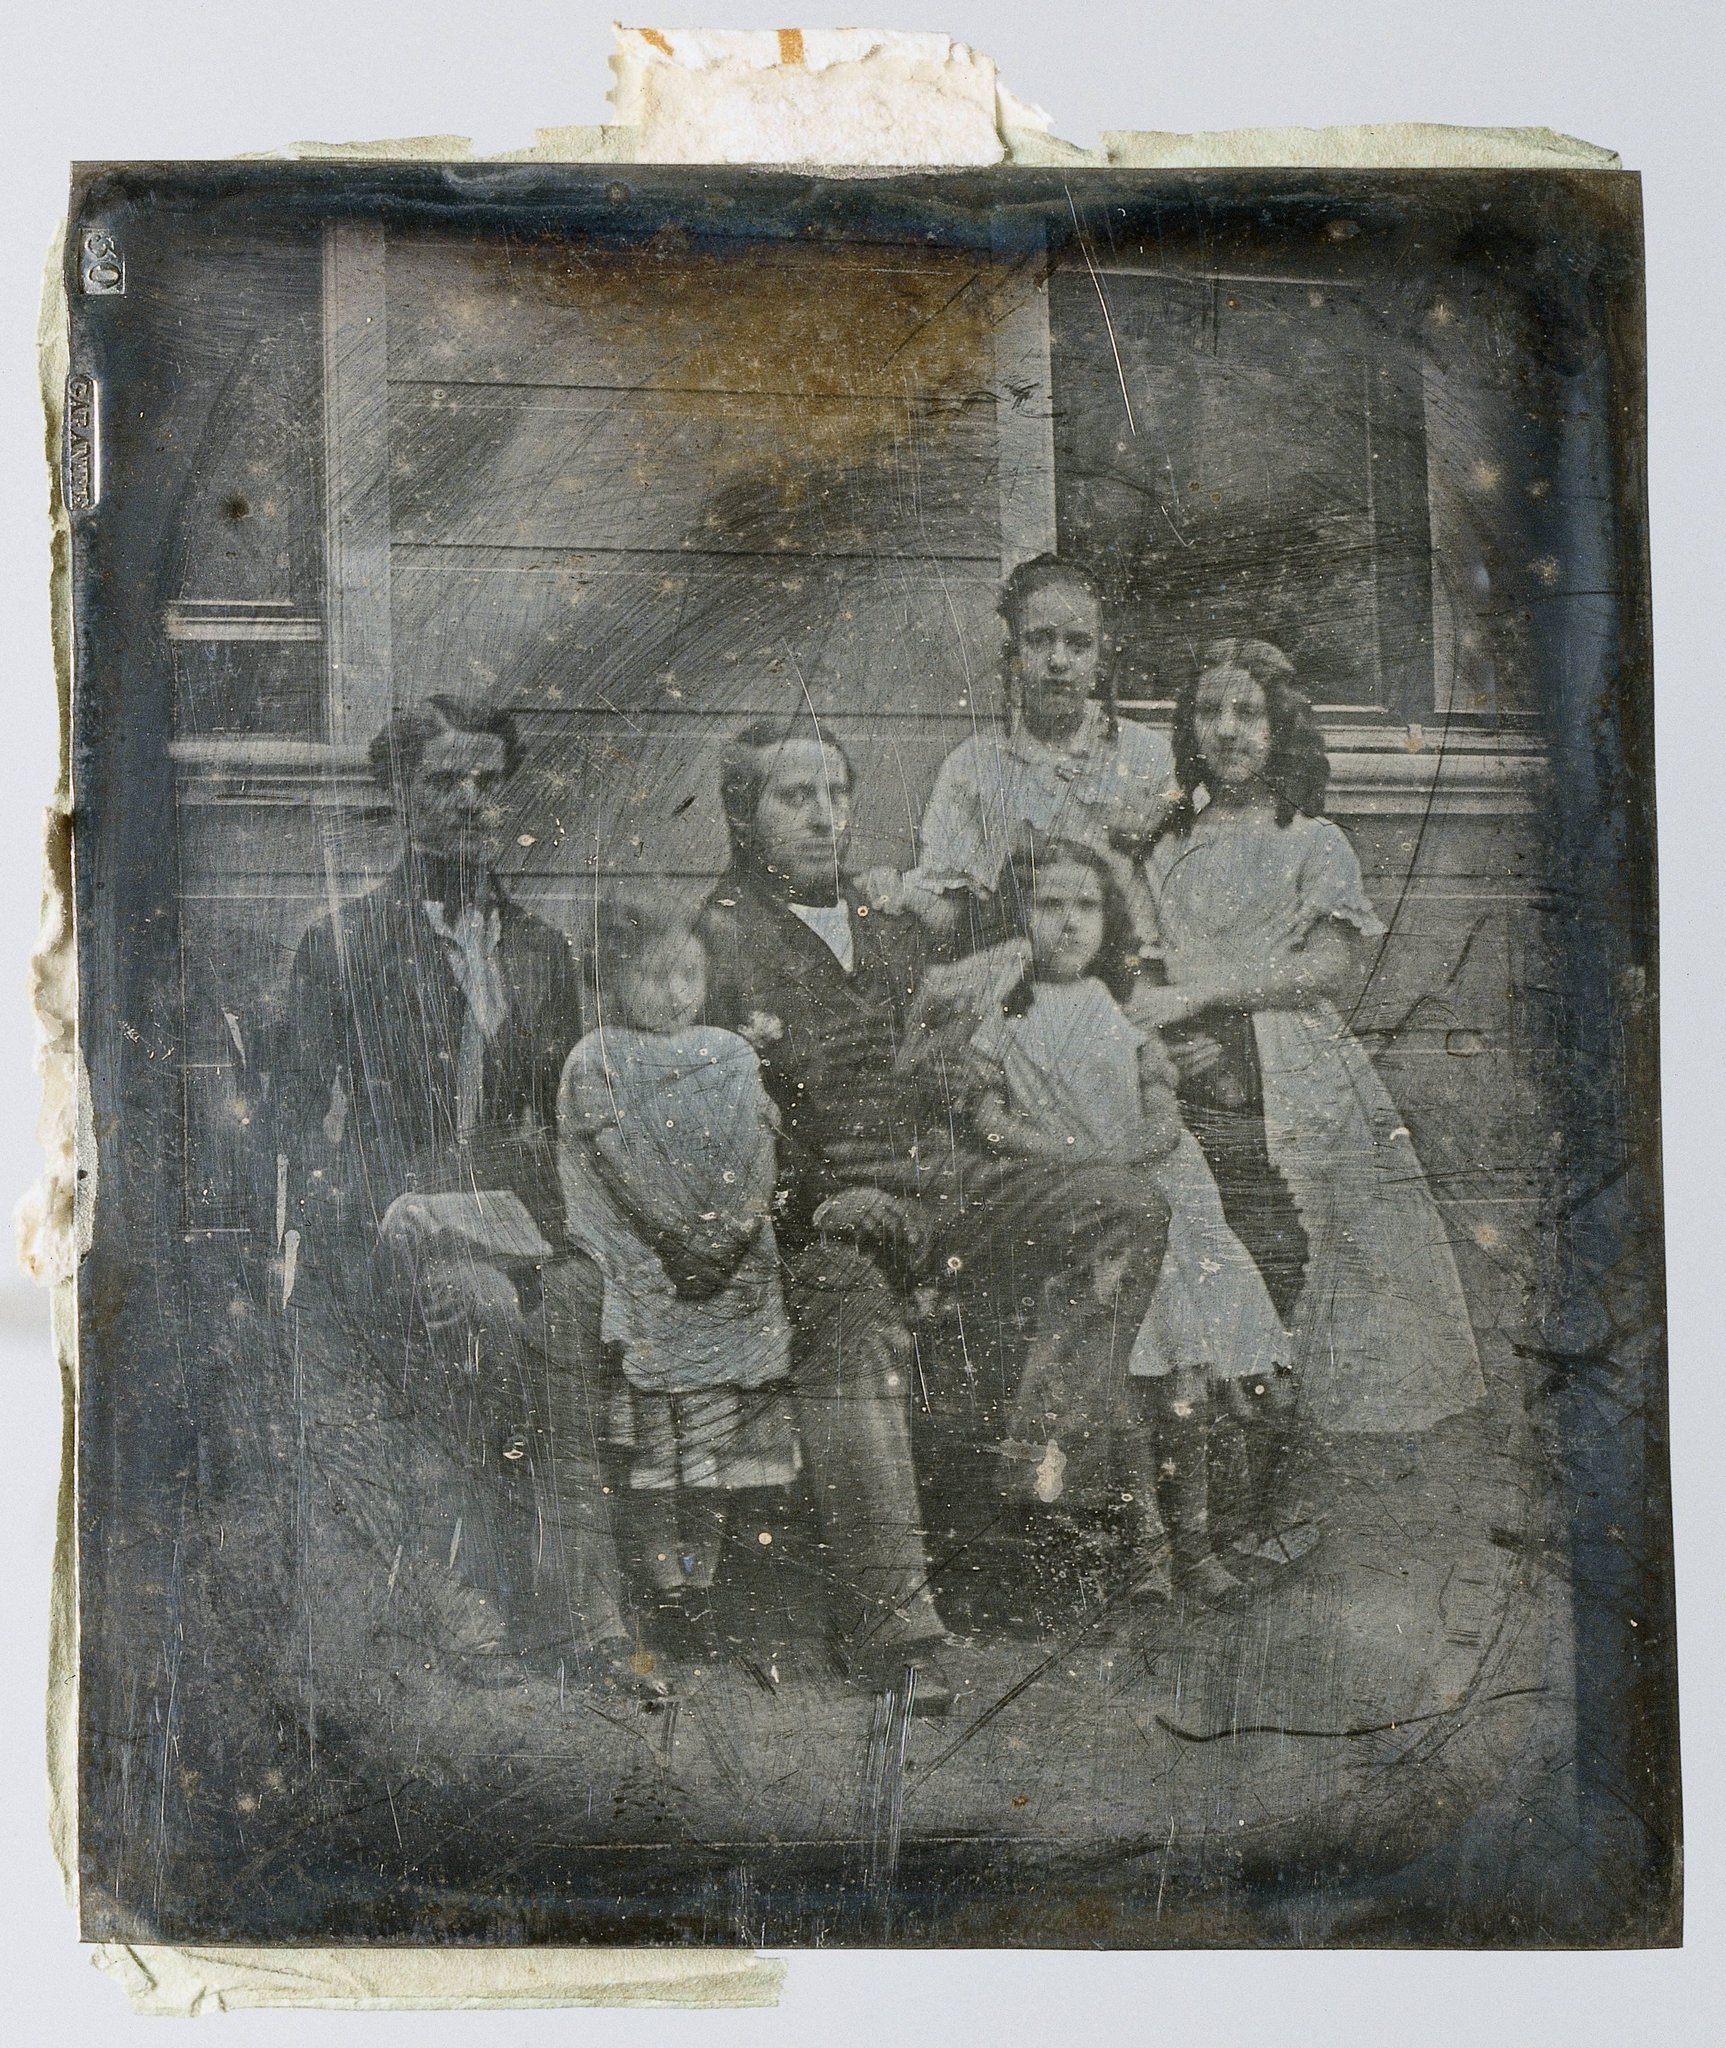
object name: photograph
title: Groepsportret van leden van de familie Asser en Oppenheim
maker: eduard isaac asser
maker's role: amateurfotograaf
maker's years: 1809-1894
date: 1846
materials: copper, glass, paper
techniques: daguerreotype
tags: family group, especially parents with their child(ren)